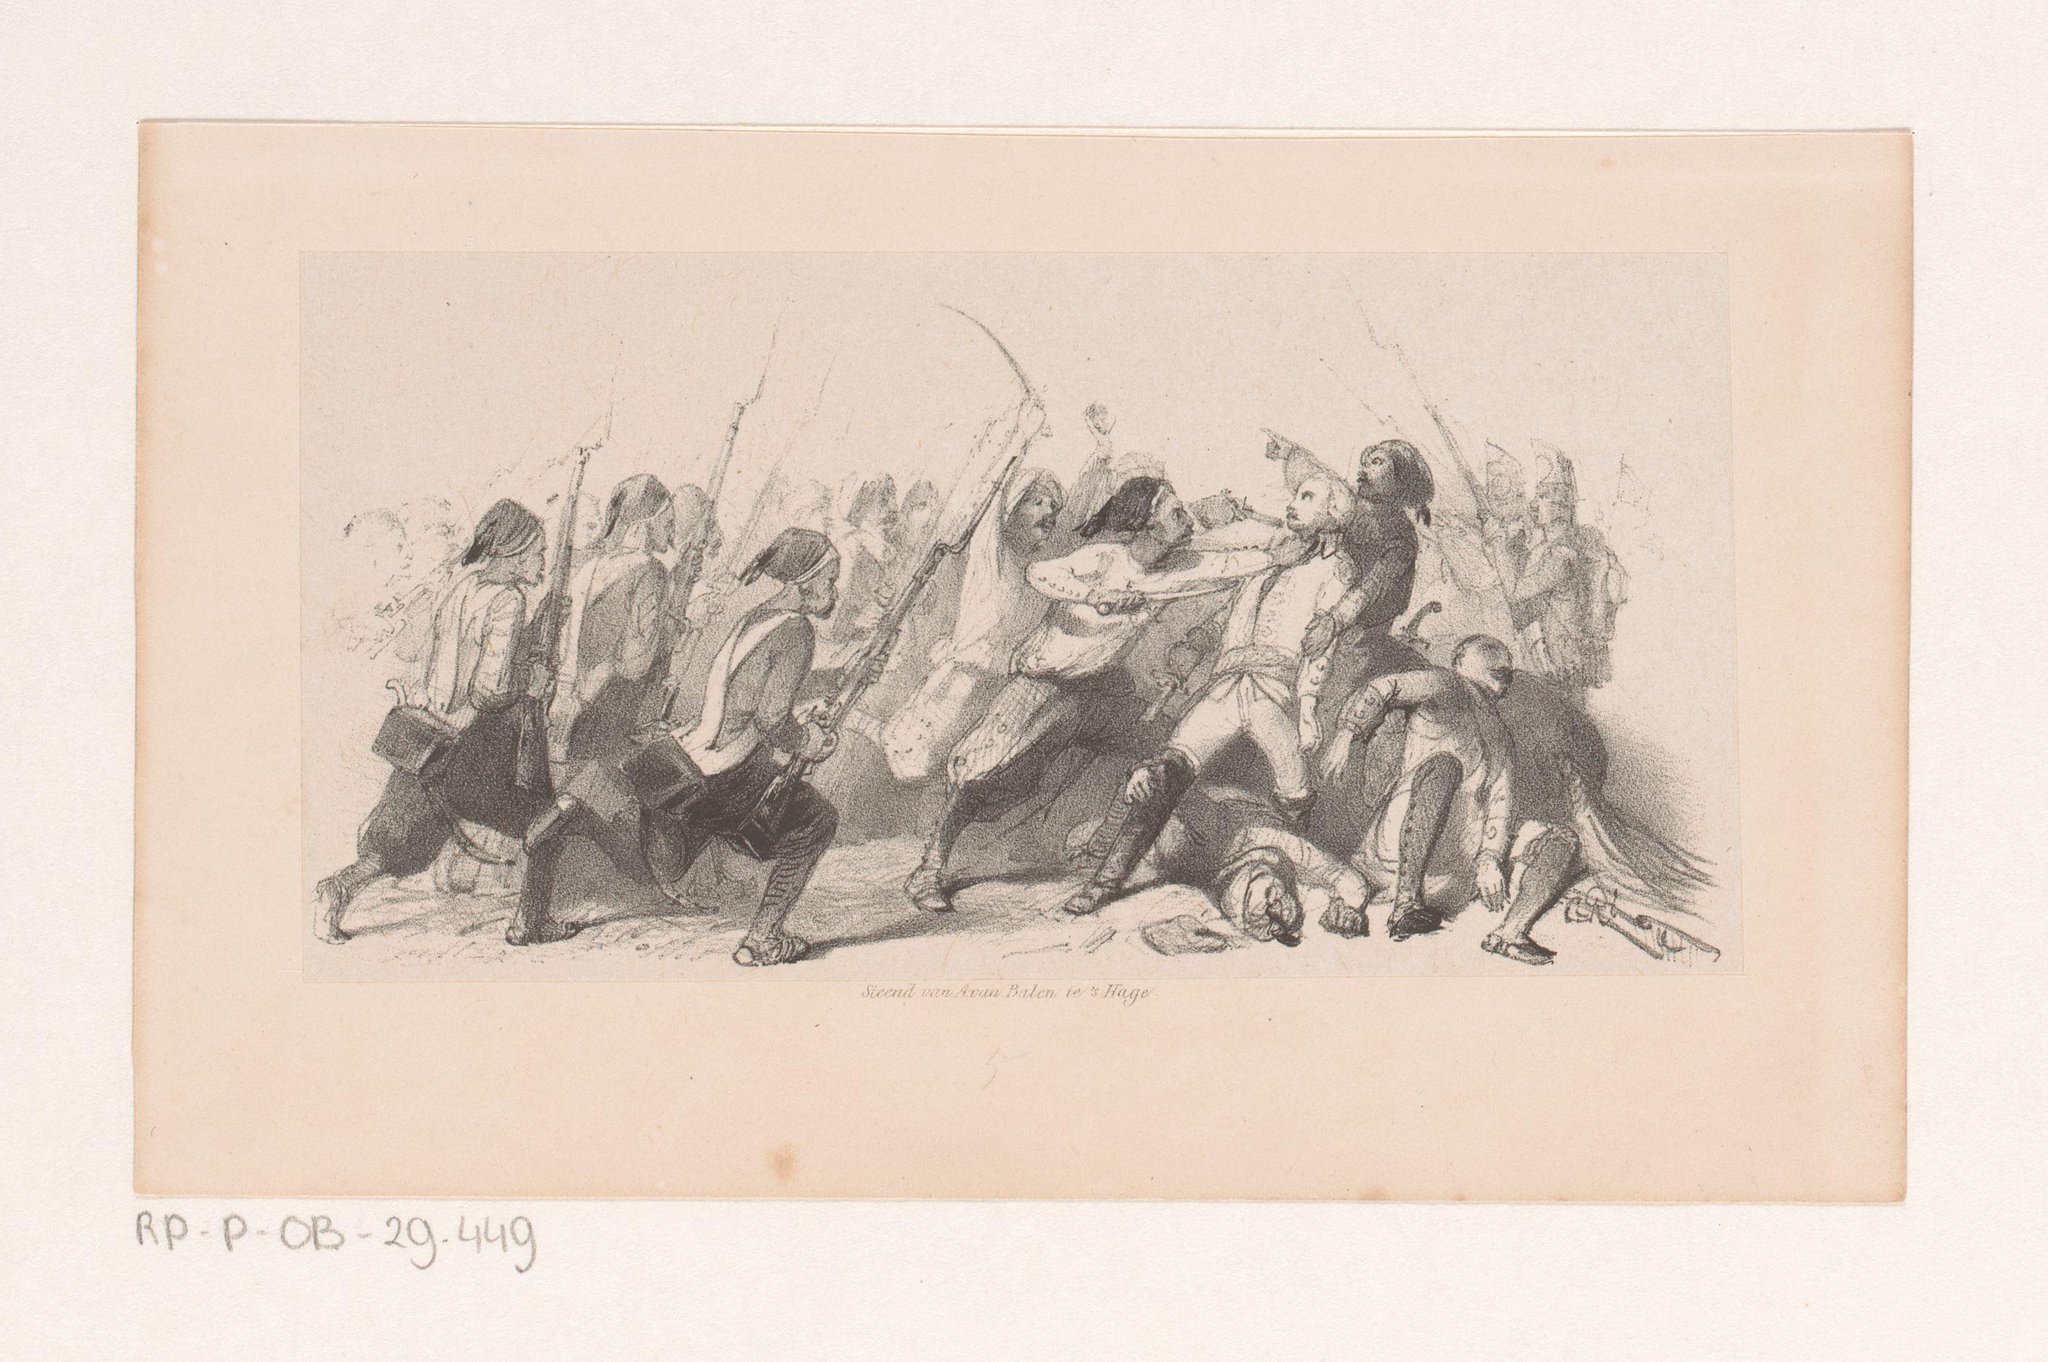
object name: print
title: Baron von Münchhausen gevangen door Turken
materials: paper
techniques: lithograph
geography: the hague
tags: asiatic races and peoples: turks, baron münchausen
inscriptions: collector's mark: Lugt 2228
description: Prent uit: Raspe, Rudolf Erich. Zonderlinge reizen en lotgevallen van den Vrijheer von Münchhausen. Den Haag: Bisschop, J.H., 1843.